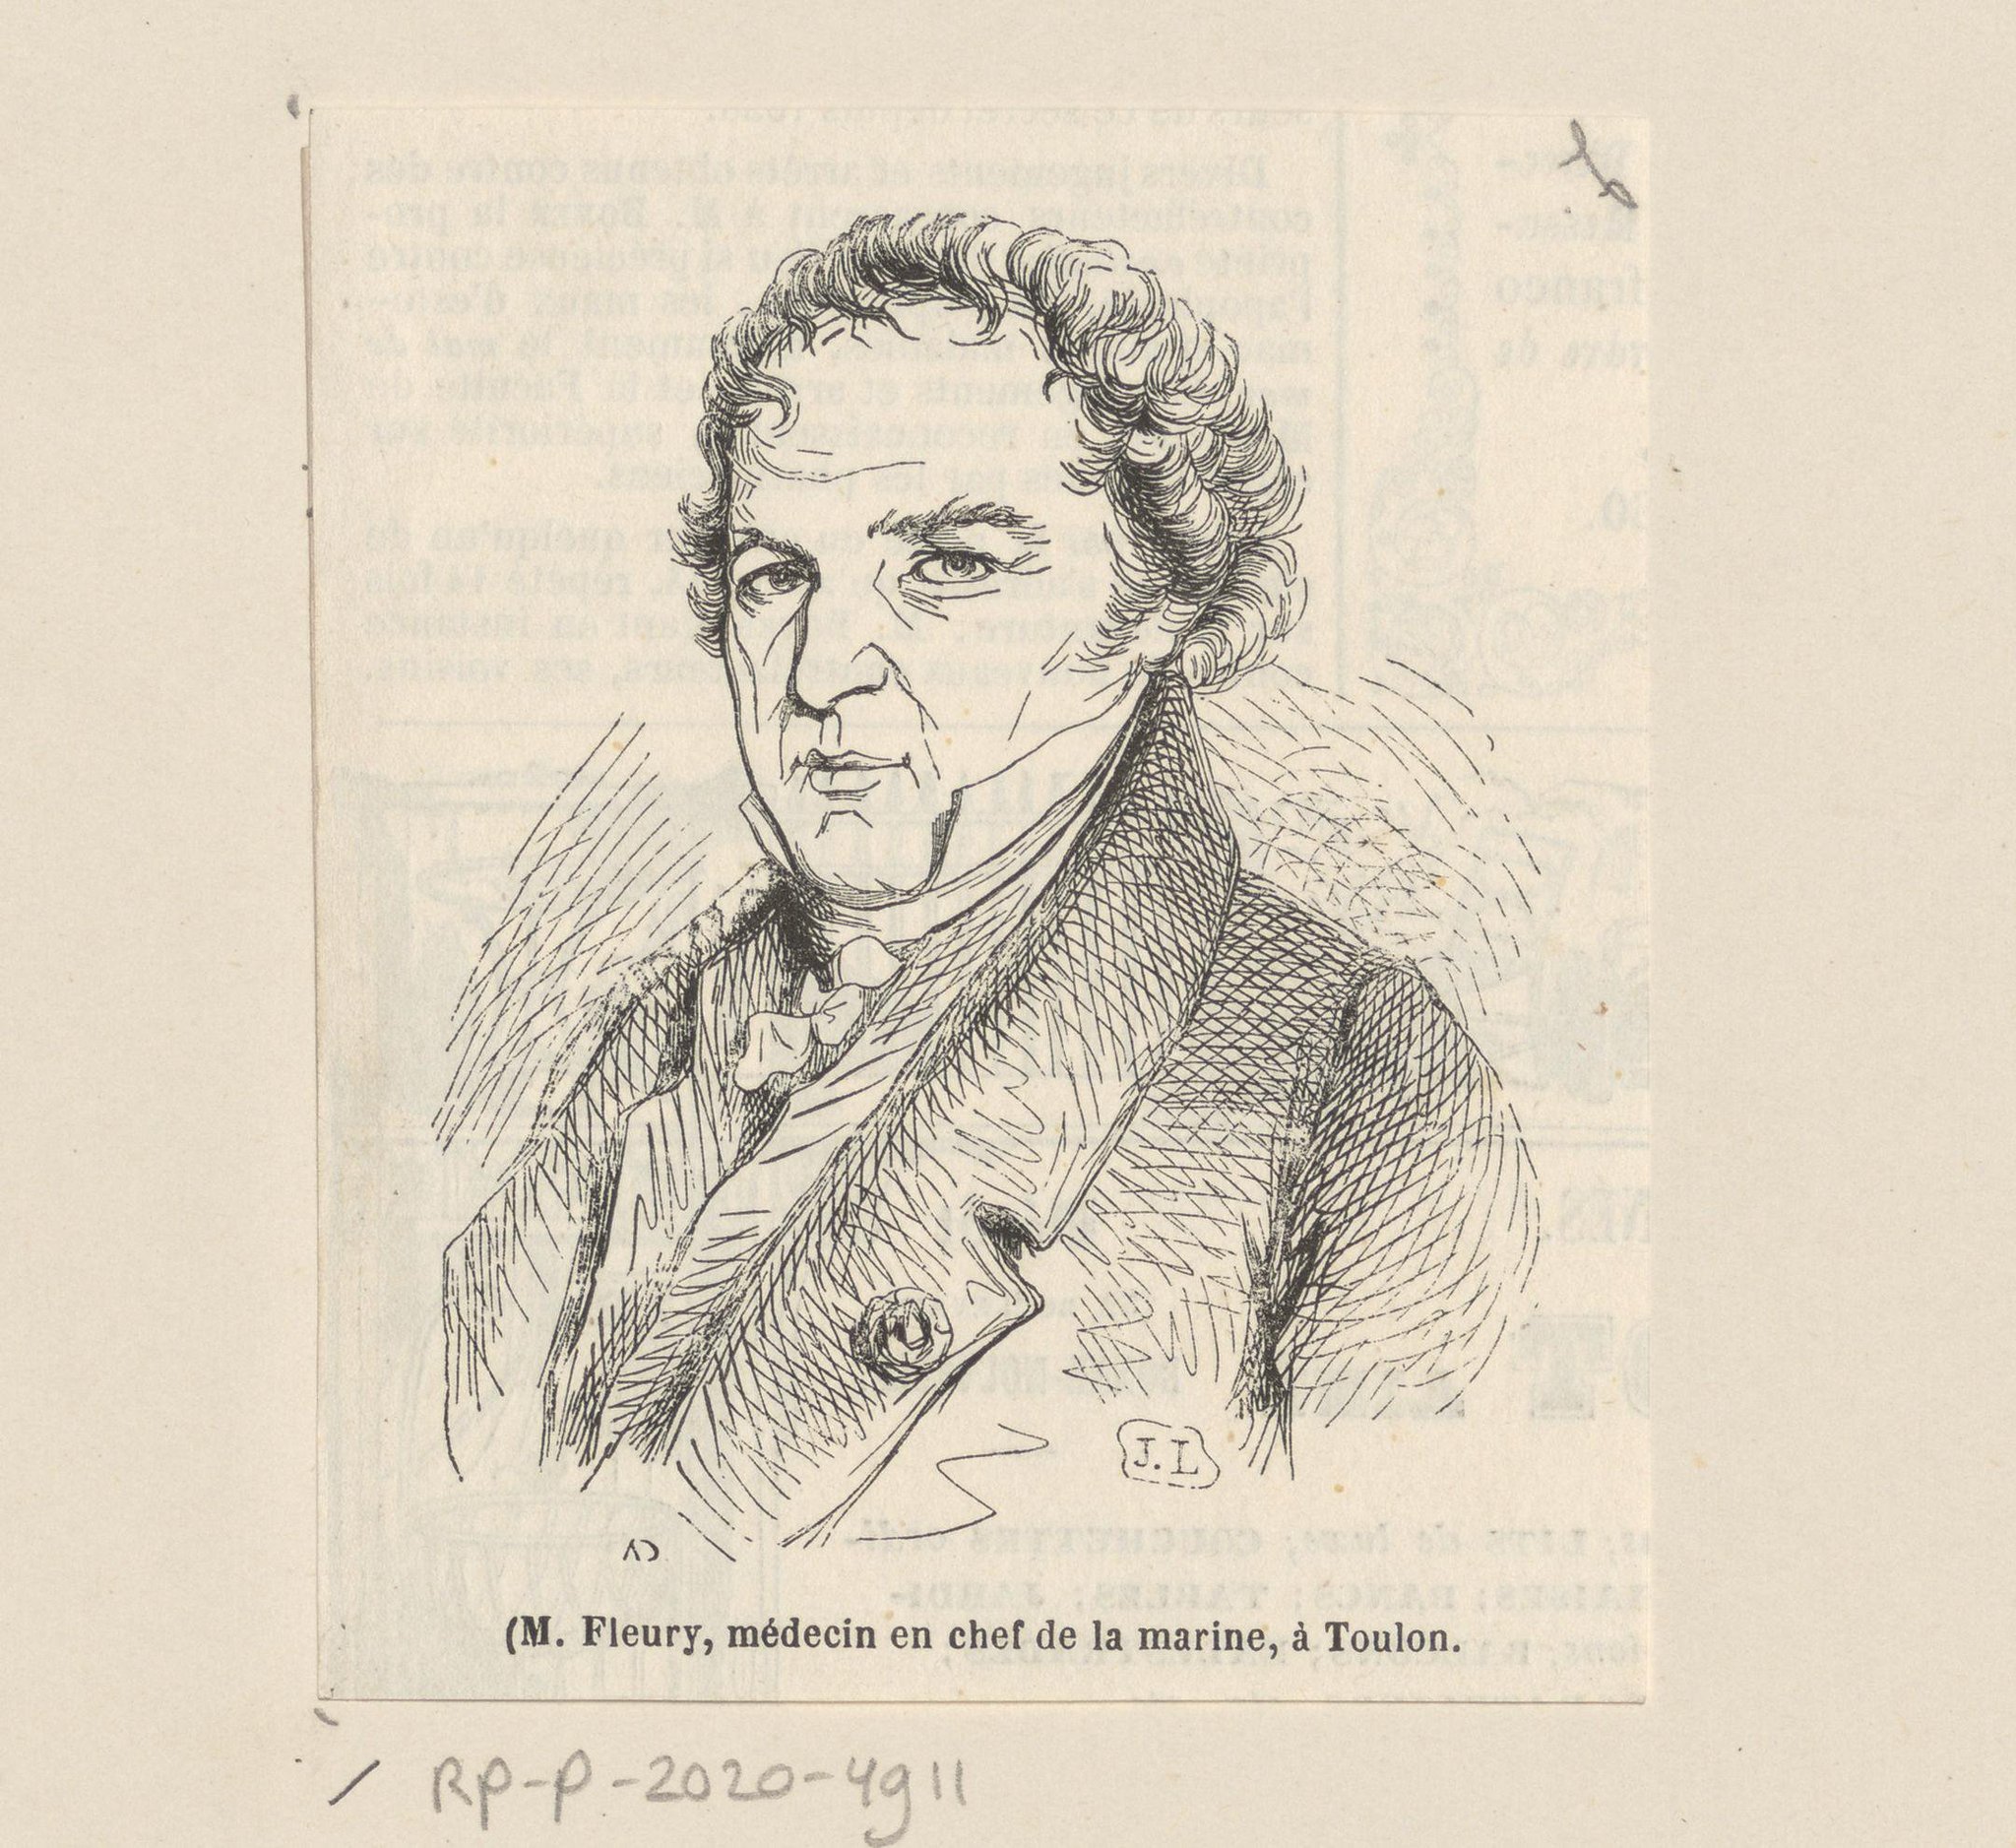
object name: photomechanical print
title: Portret van Jean André Fleury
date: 1844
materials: paper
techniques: letterpress printing, line block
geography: france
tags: historical persons, physician, doctor (+ portrait of scholar, scientist)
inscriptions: monogram: ‘J.L.’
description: Prent uit: L'Illustration 3 (1844), nr. 78, 24 augustus 1844.